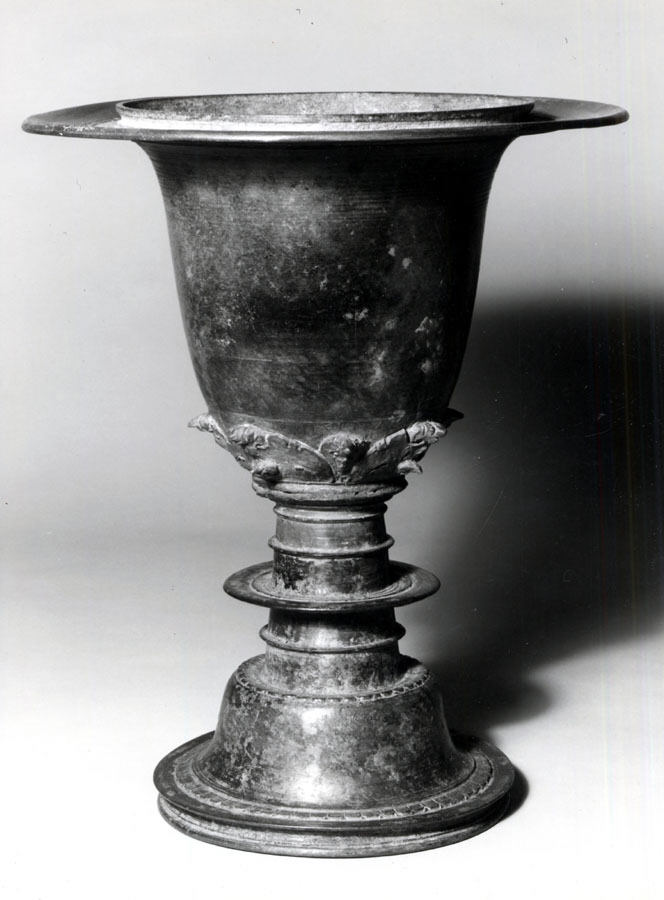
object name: vase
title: Open Vase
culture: indonesian, javanese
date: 901-1100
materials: bronze